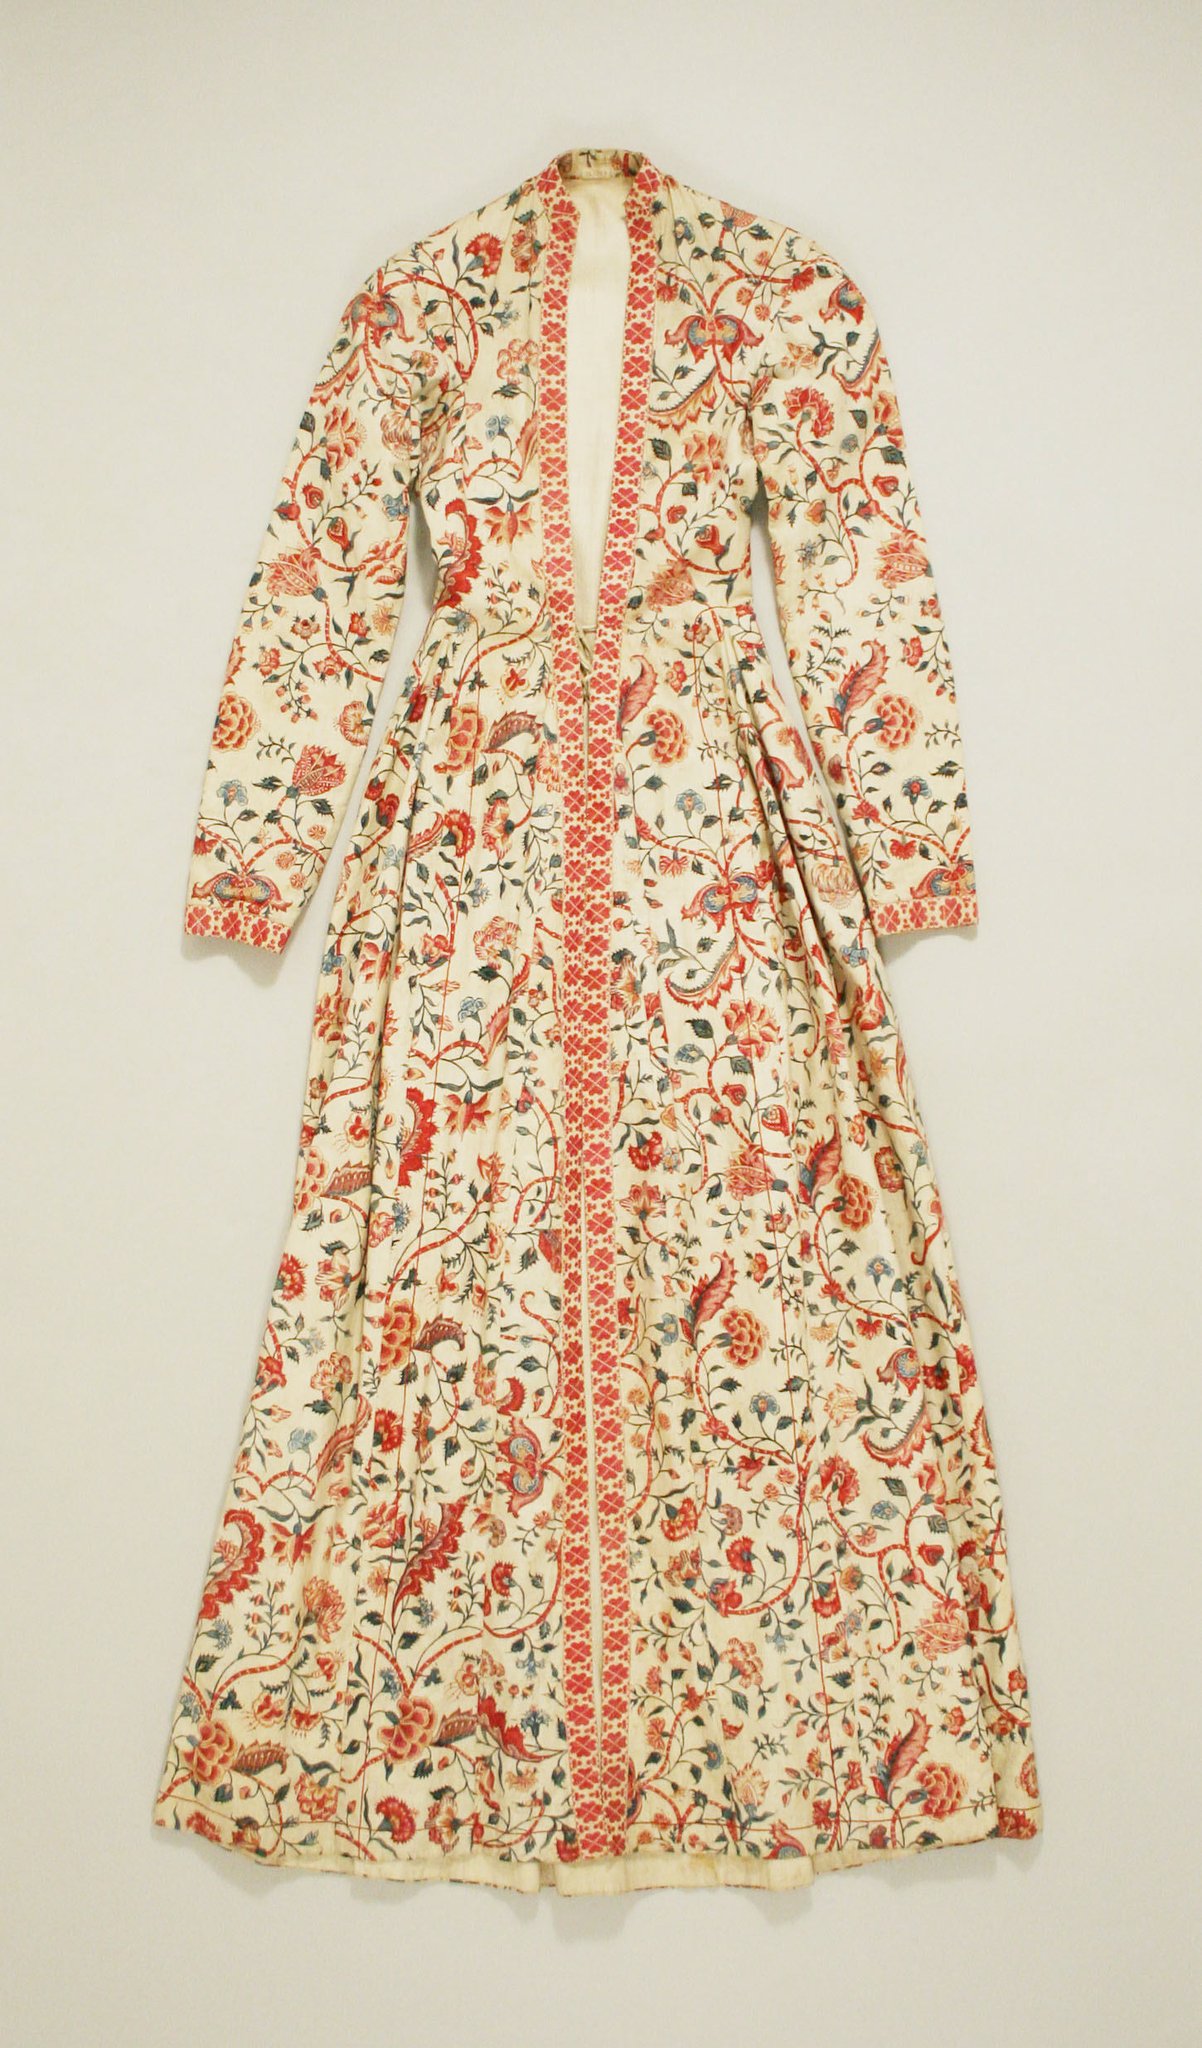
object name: dress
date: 1701-1900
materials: cotton